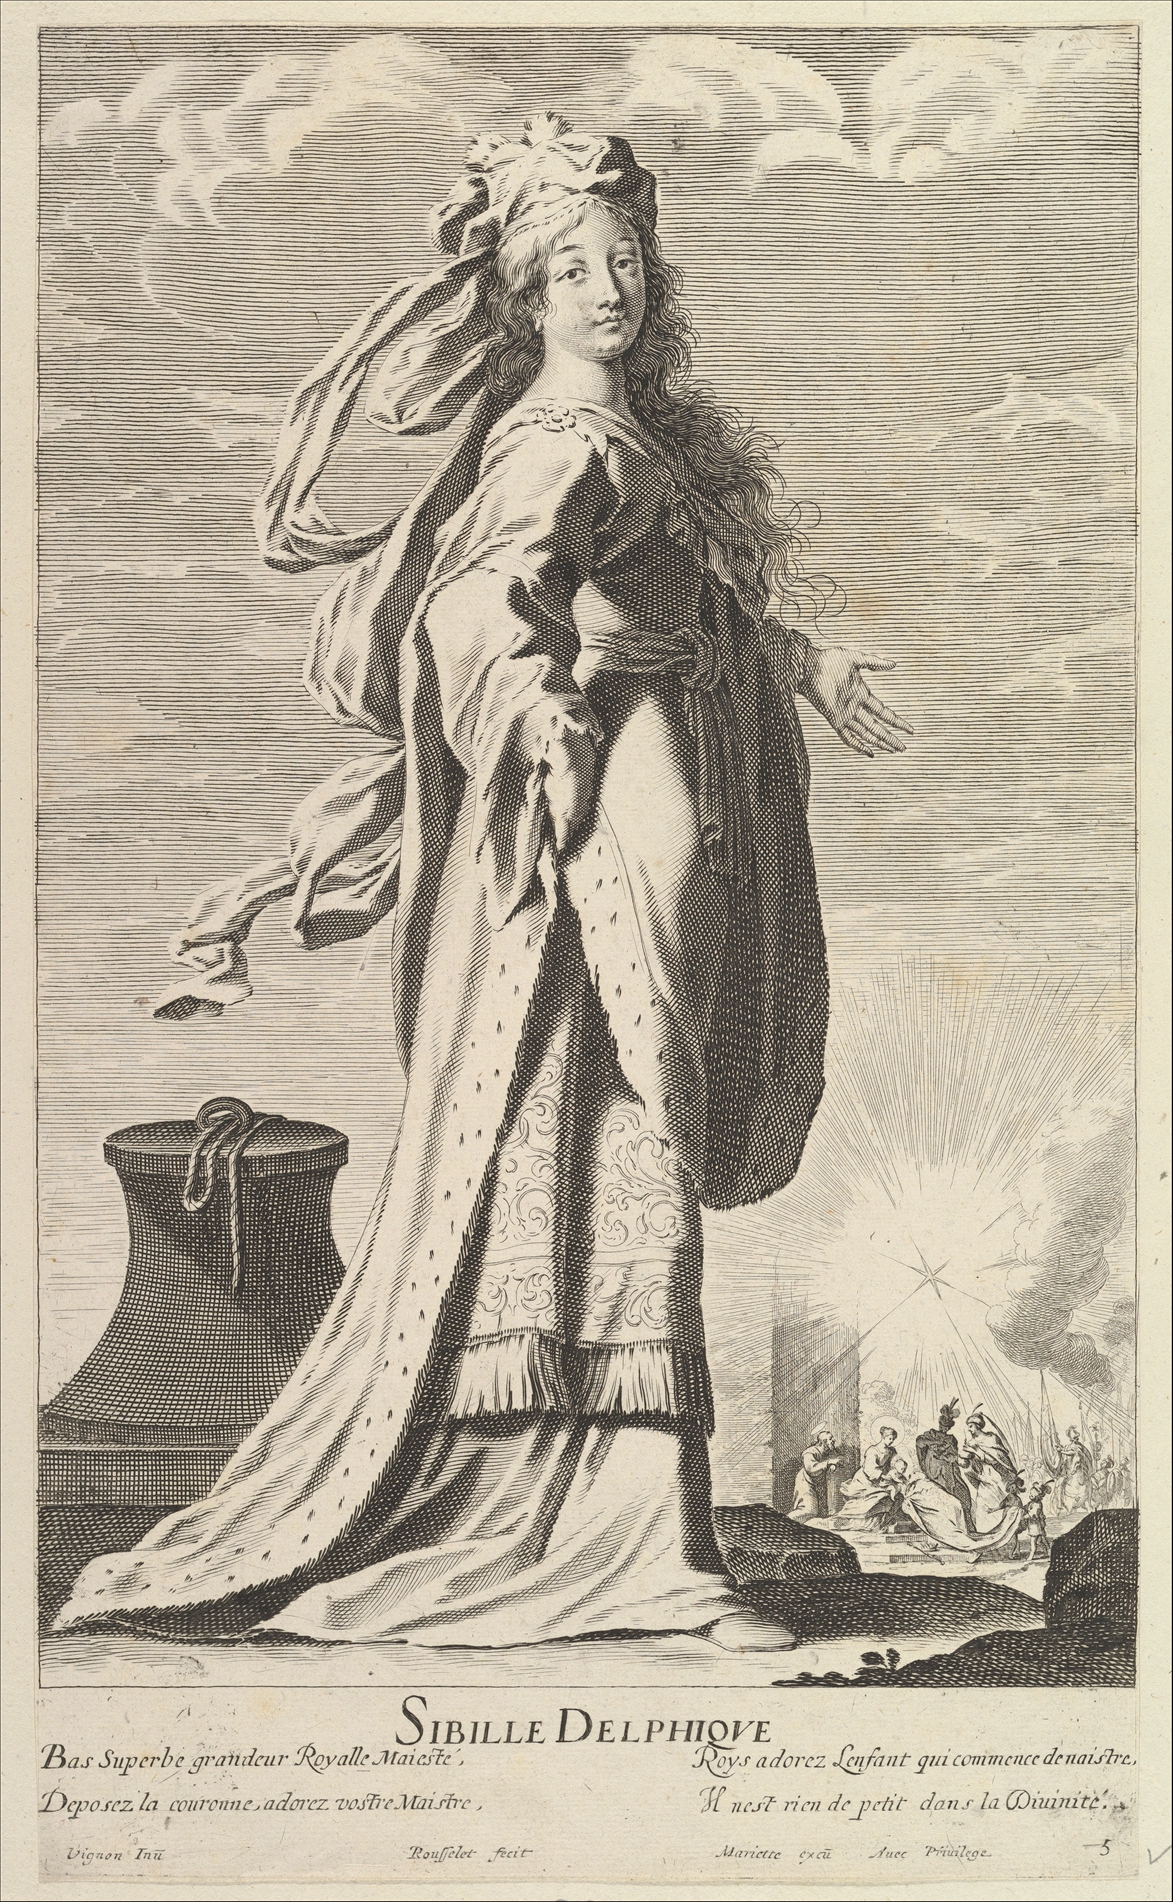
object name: print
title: Sibylle Delphique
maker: gilles rousselet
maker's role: artist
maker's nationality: french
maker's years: 1614-1686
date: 1635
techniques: engraving, etching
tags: women